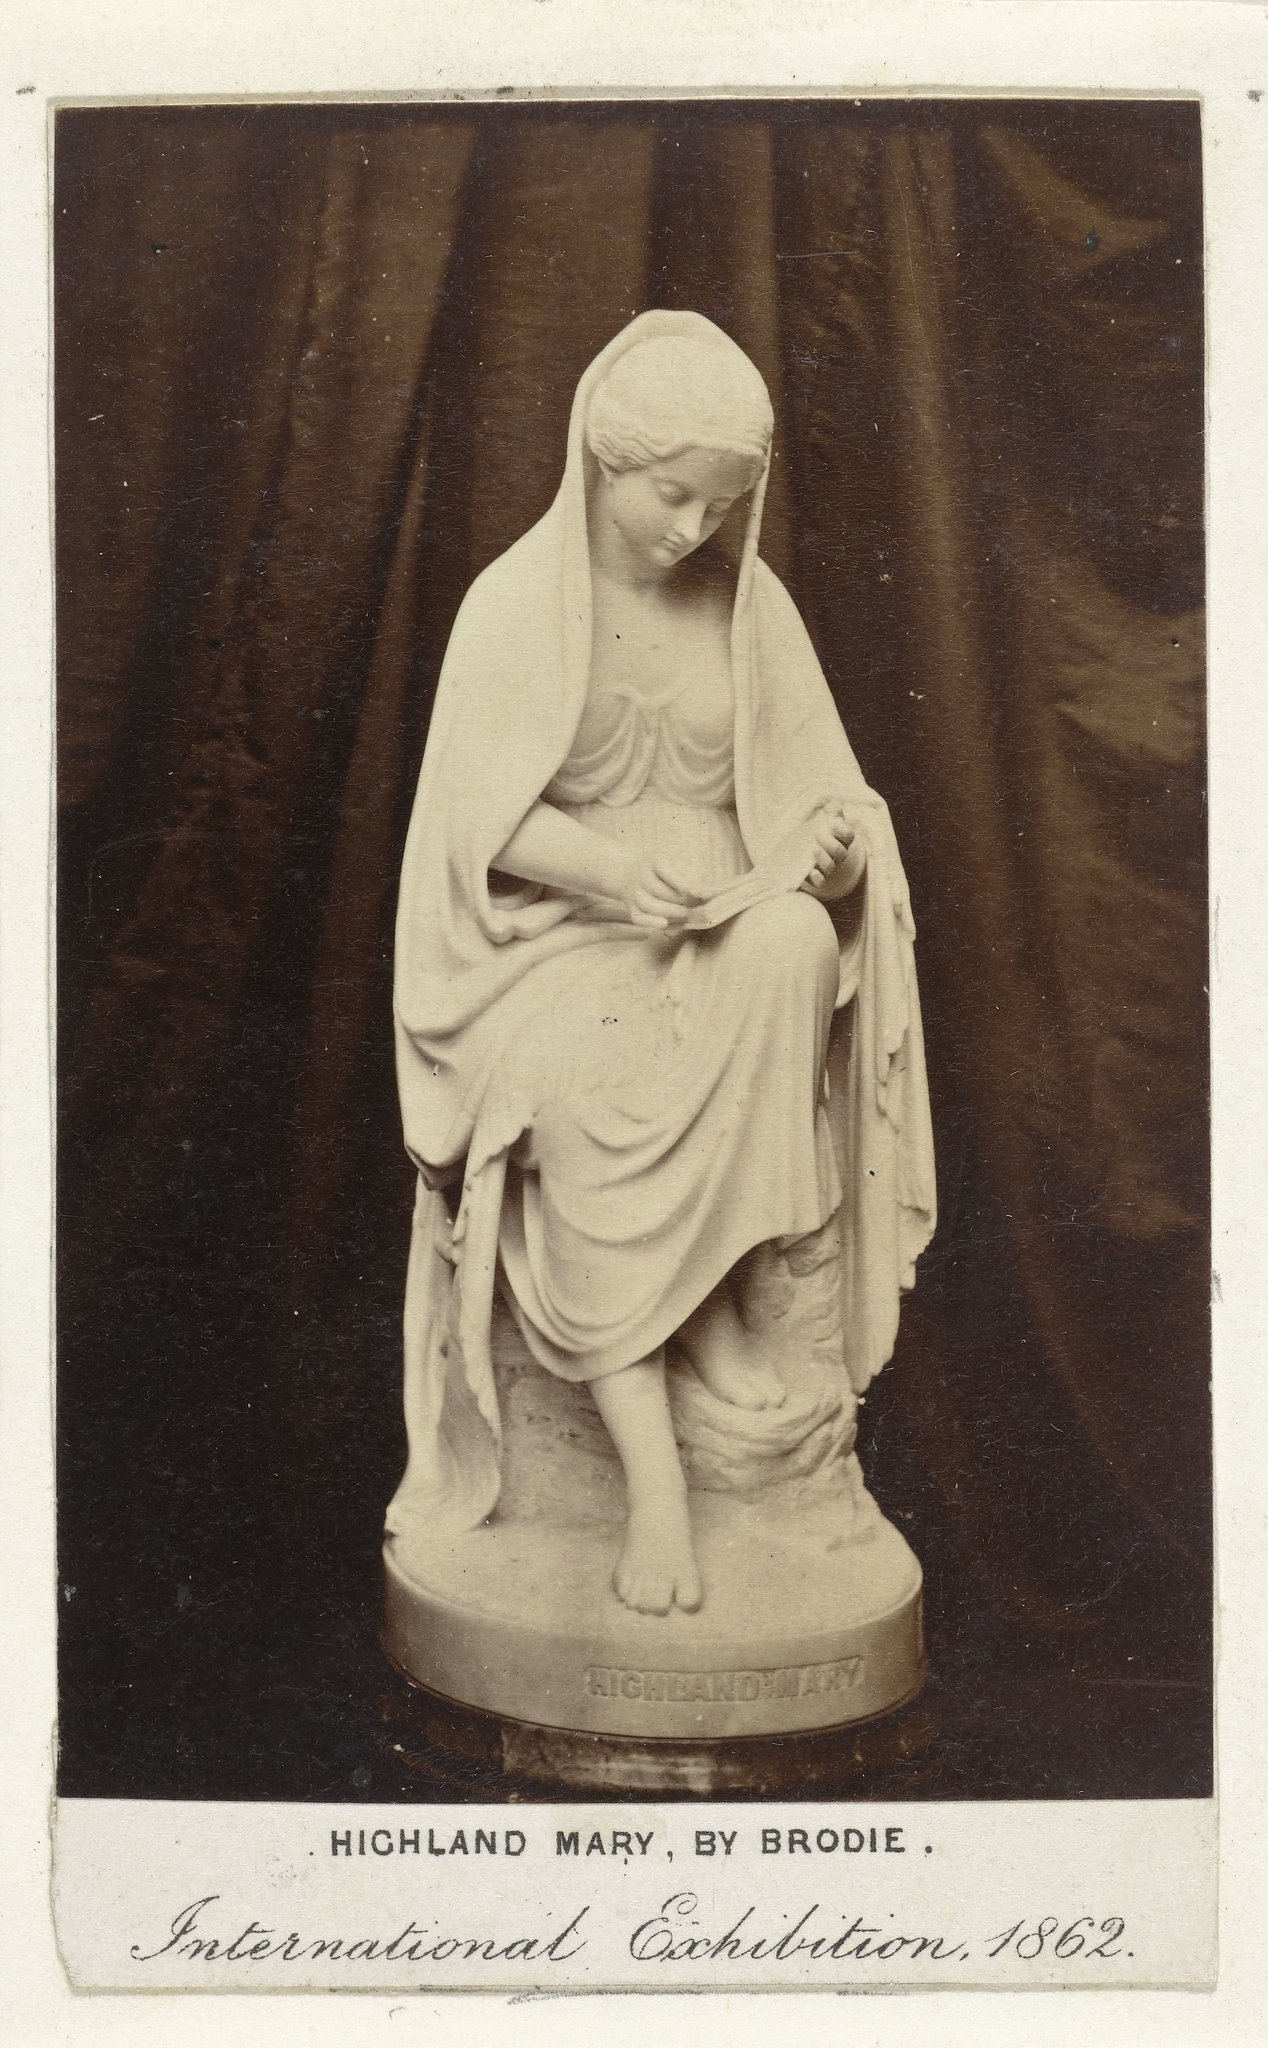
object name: carte de visite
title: Highland Mary, by Brodie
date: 1862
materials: cardboard, paper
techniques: albumen print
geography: london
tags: sculpture, london